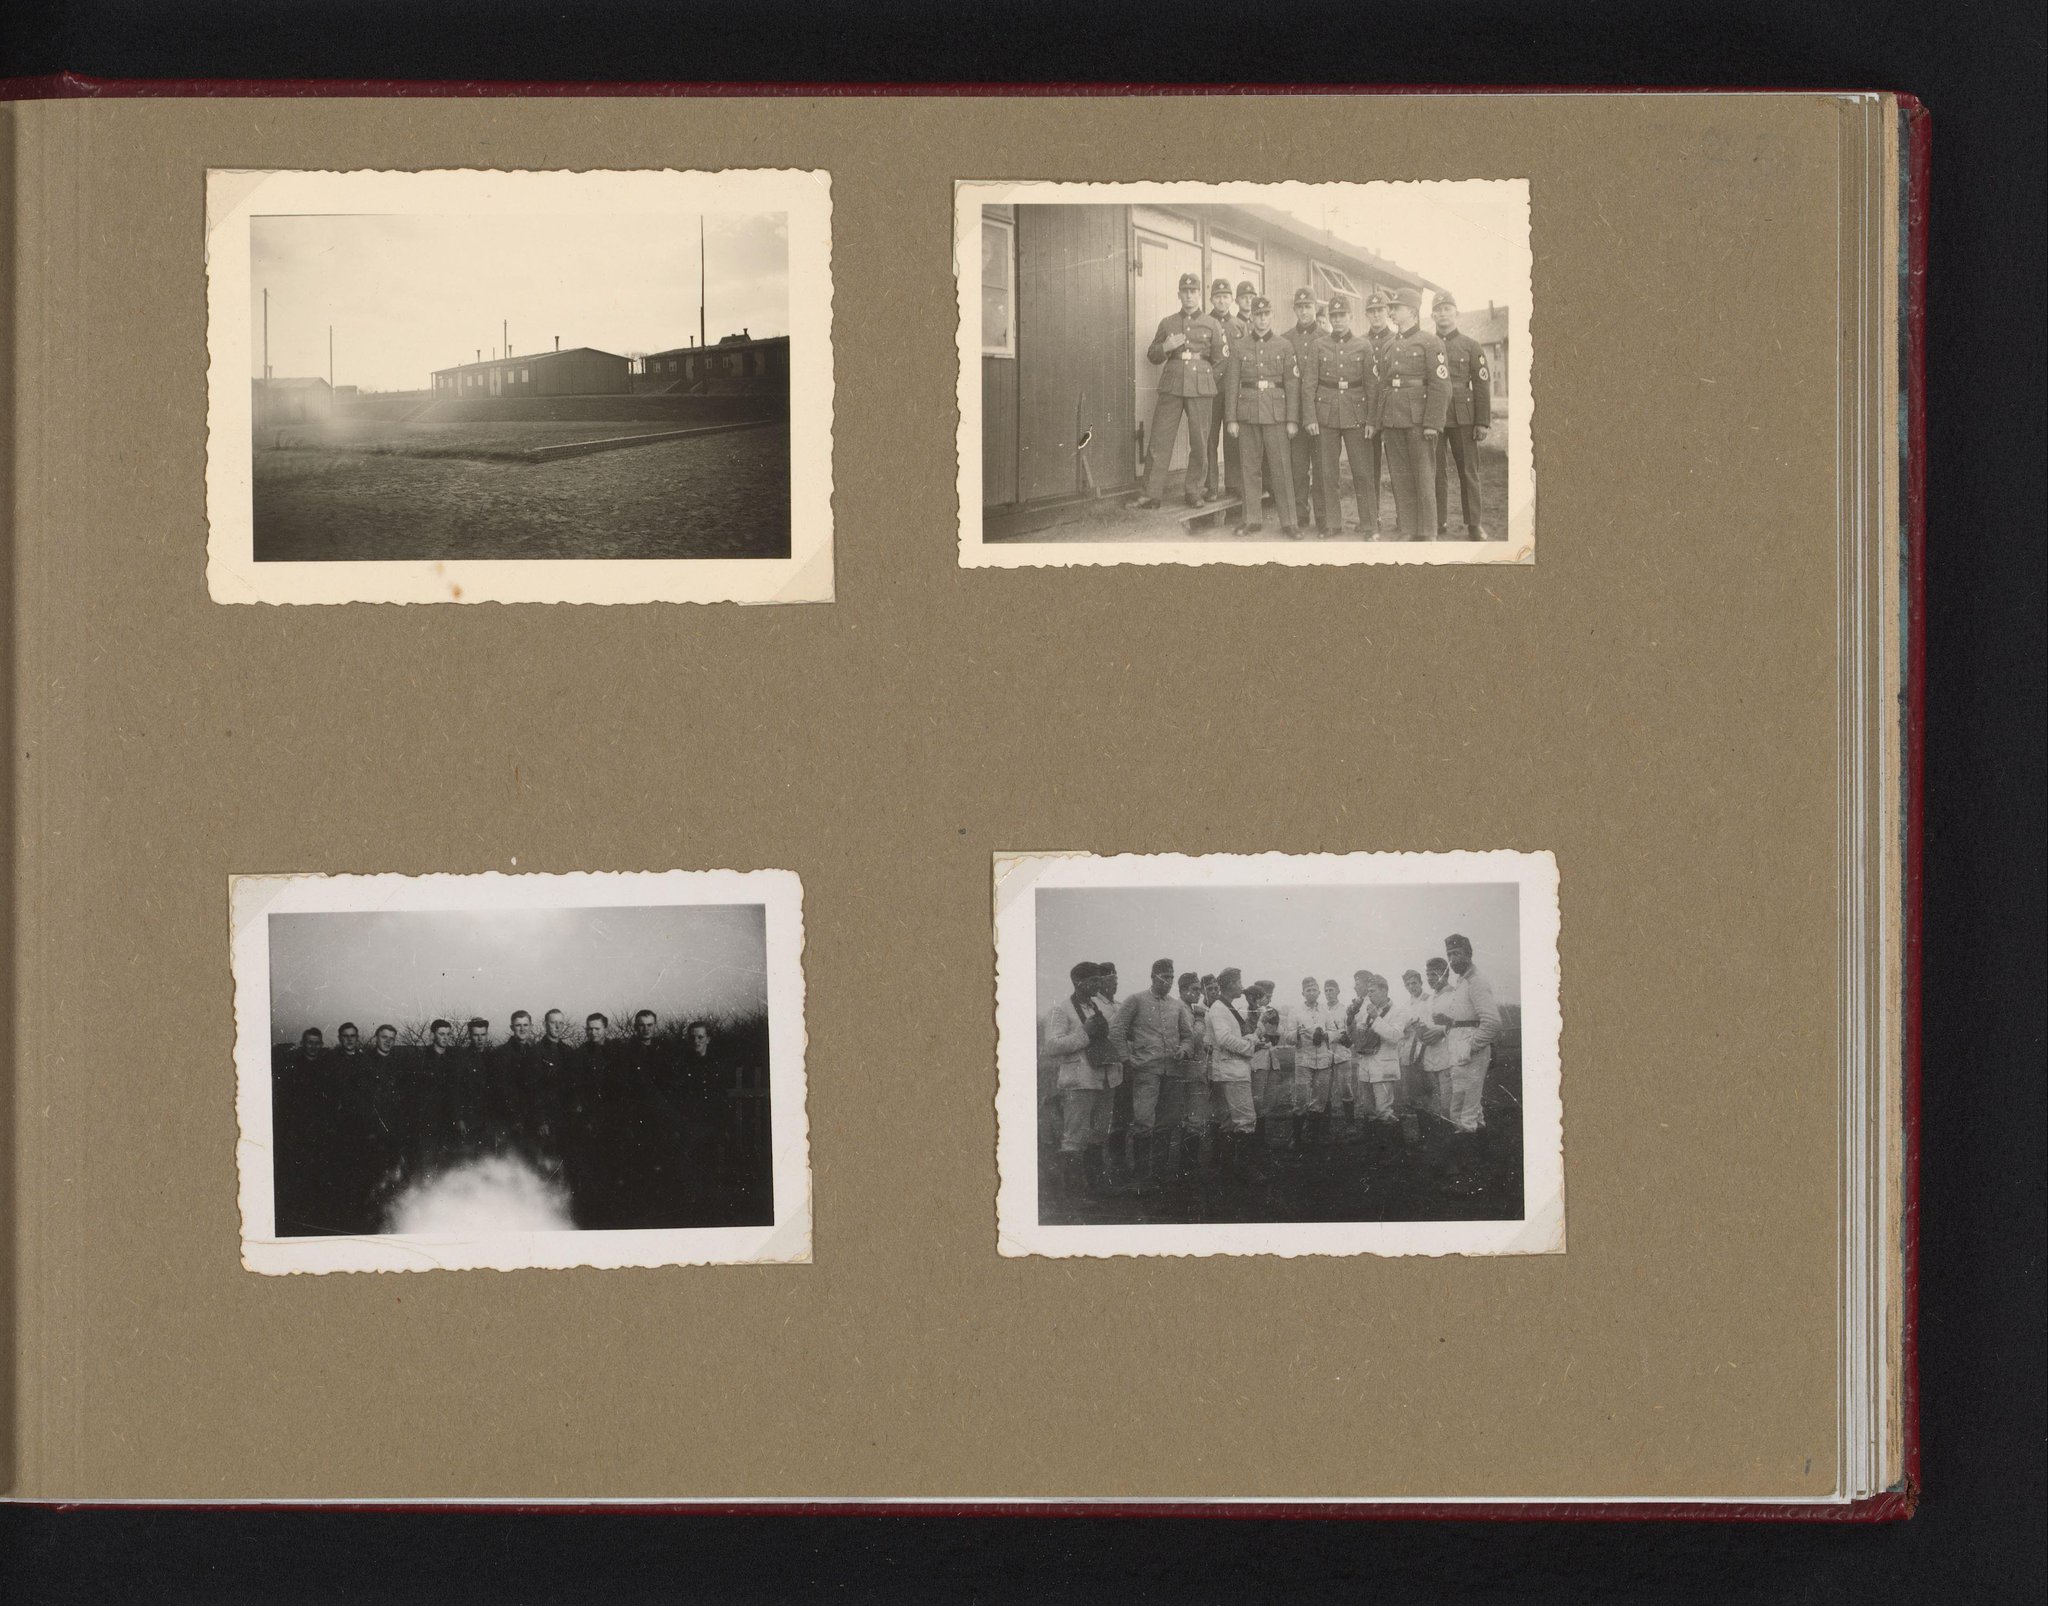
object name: album leaf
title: Groepsfoto's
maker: Anonymous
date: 1939-1943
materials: paper, photographic support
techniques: gelatin silver print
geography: germany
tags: the company, the unit, the troop ~ military service, barracks, germany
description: Albumblad met vier foto's van groepen soldaten en van barakken. Onderdeel van het fotoalbum over soldaten van de Wehrmacht, ca. 1939-1943.